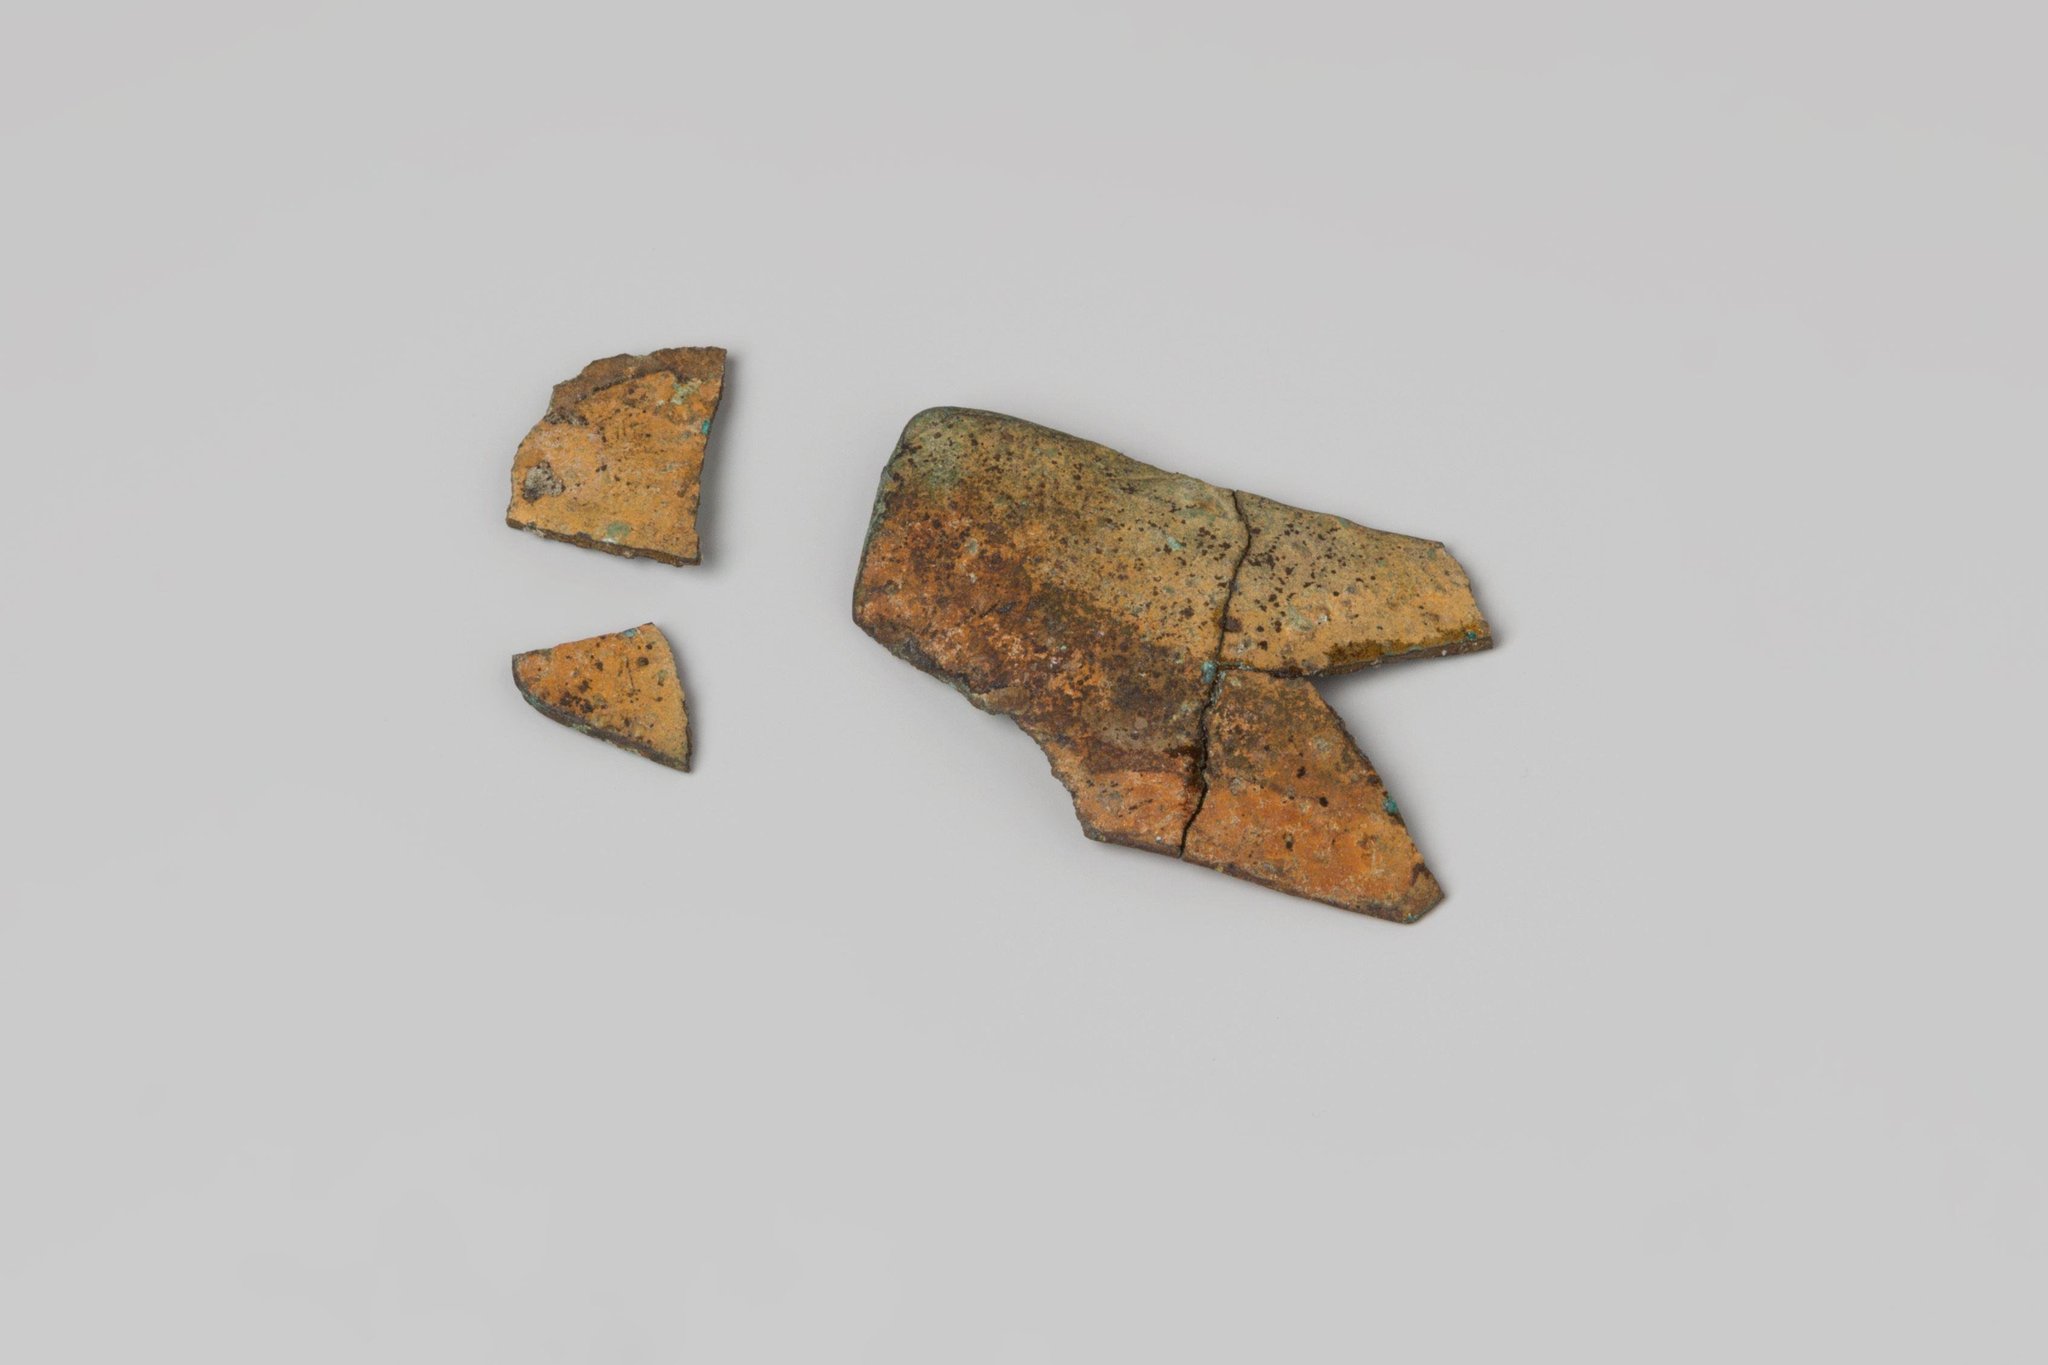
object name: fragment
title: Fragmenten koper uit het wrak van de Oost-Indiëvaarder Hollandia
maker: Anonymous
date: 1700-1743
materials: copper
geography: netherlands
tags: verenigde oostindische compagnie, hollandia (schip), annet